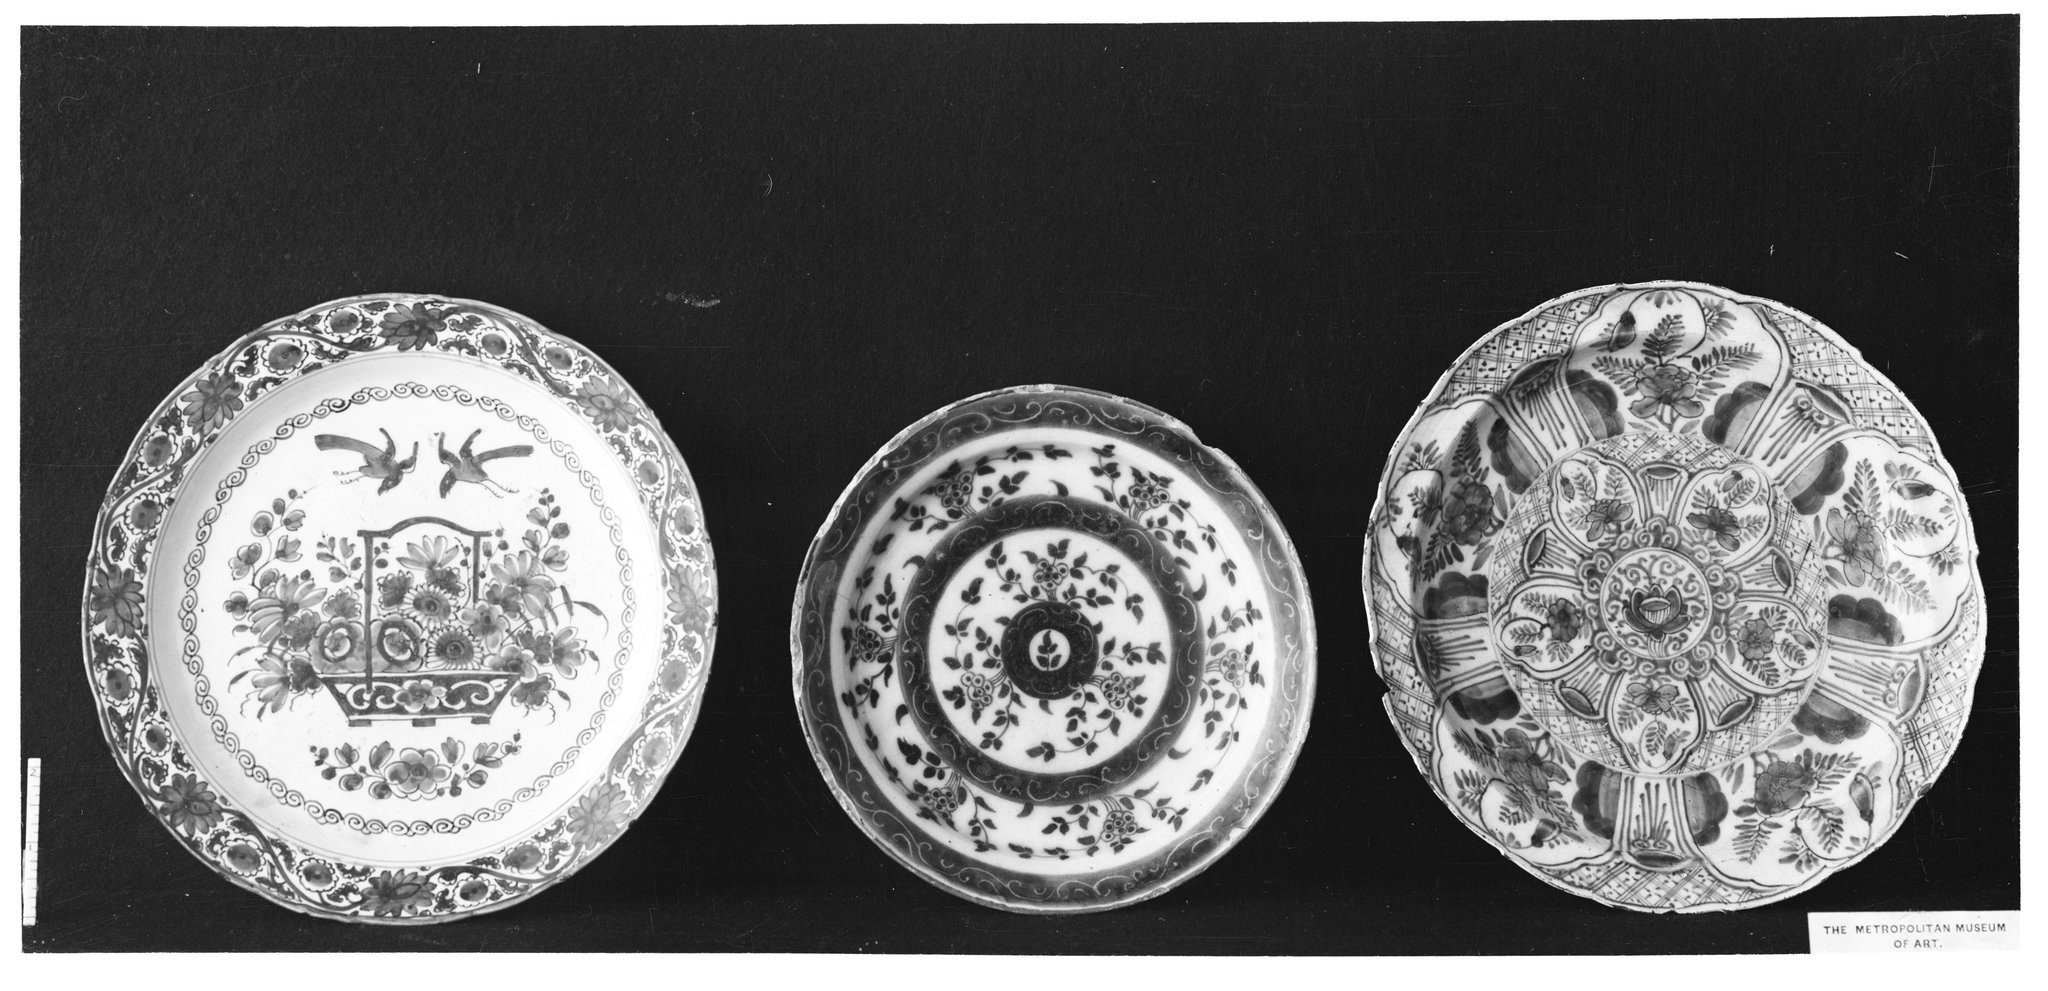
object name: plate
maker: the "greek a" factory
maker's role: manufactory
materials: faience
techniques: glazing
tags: birds,flowers